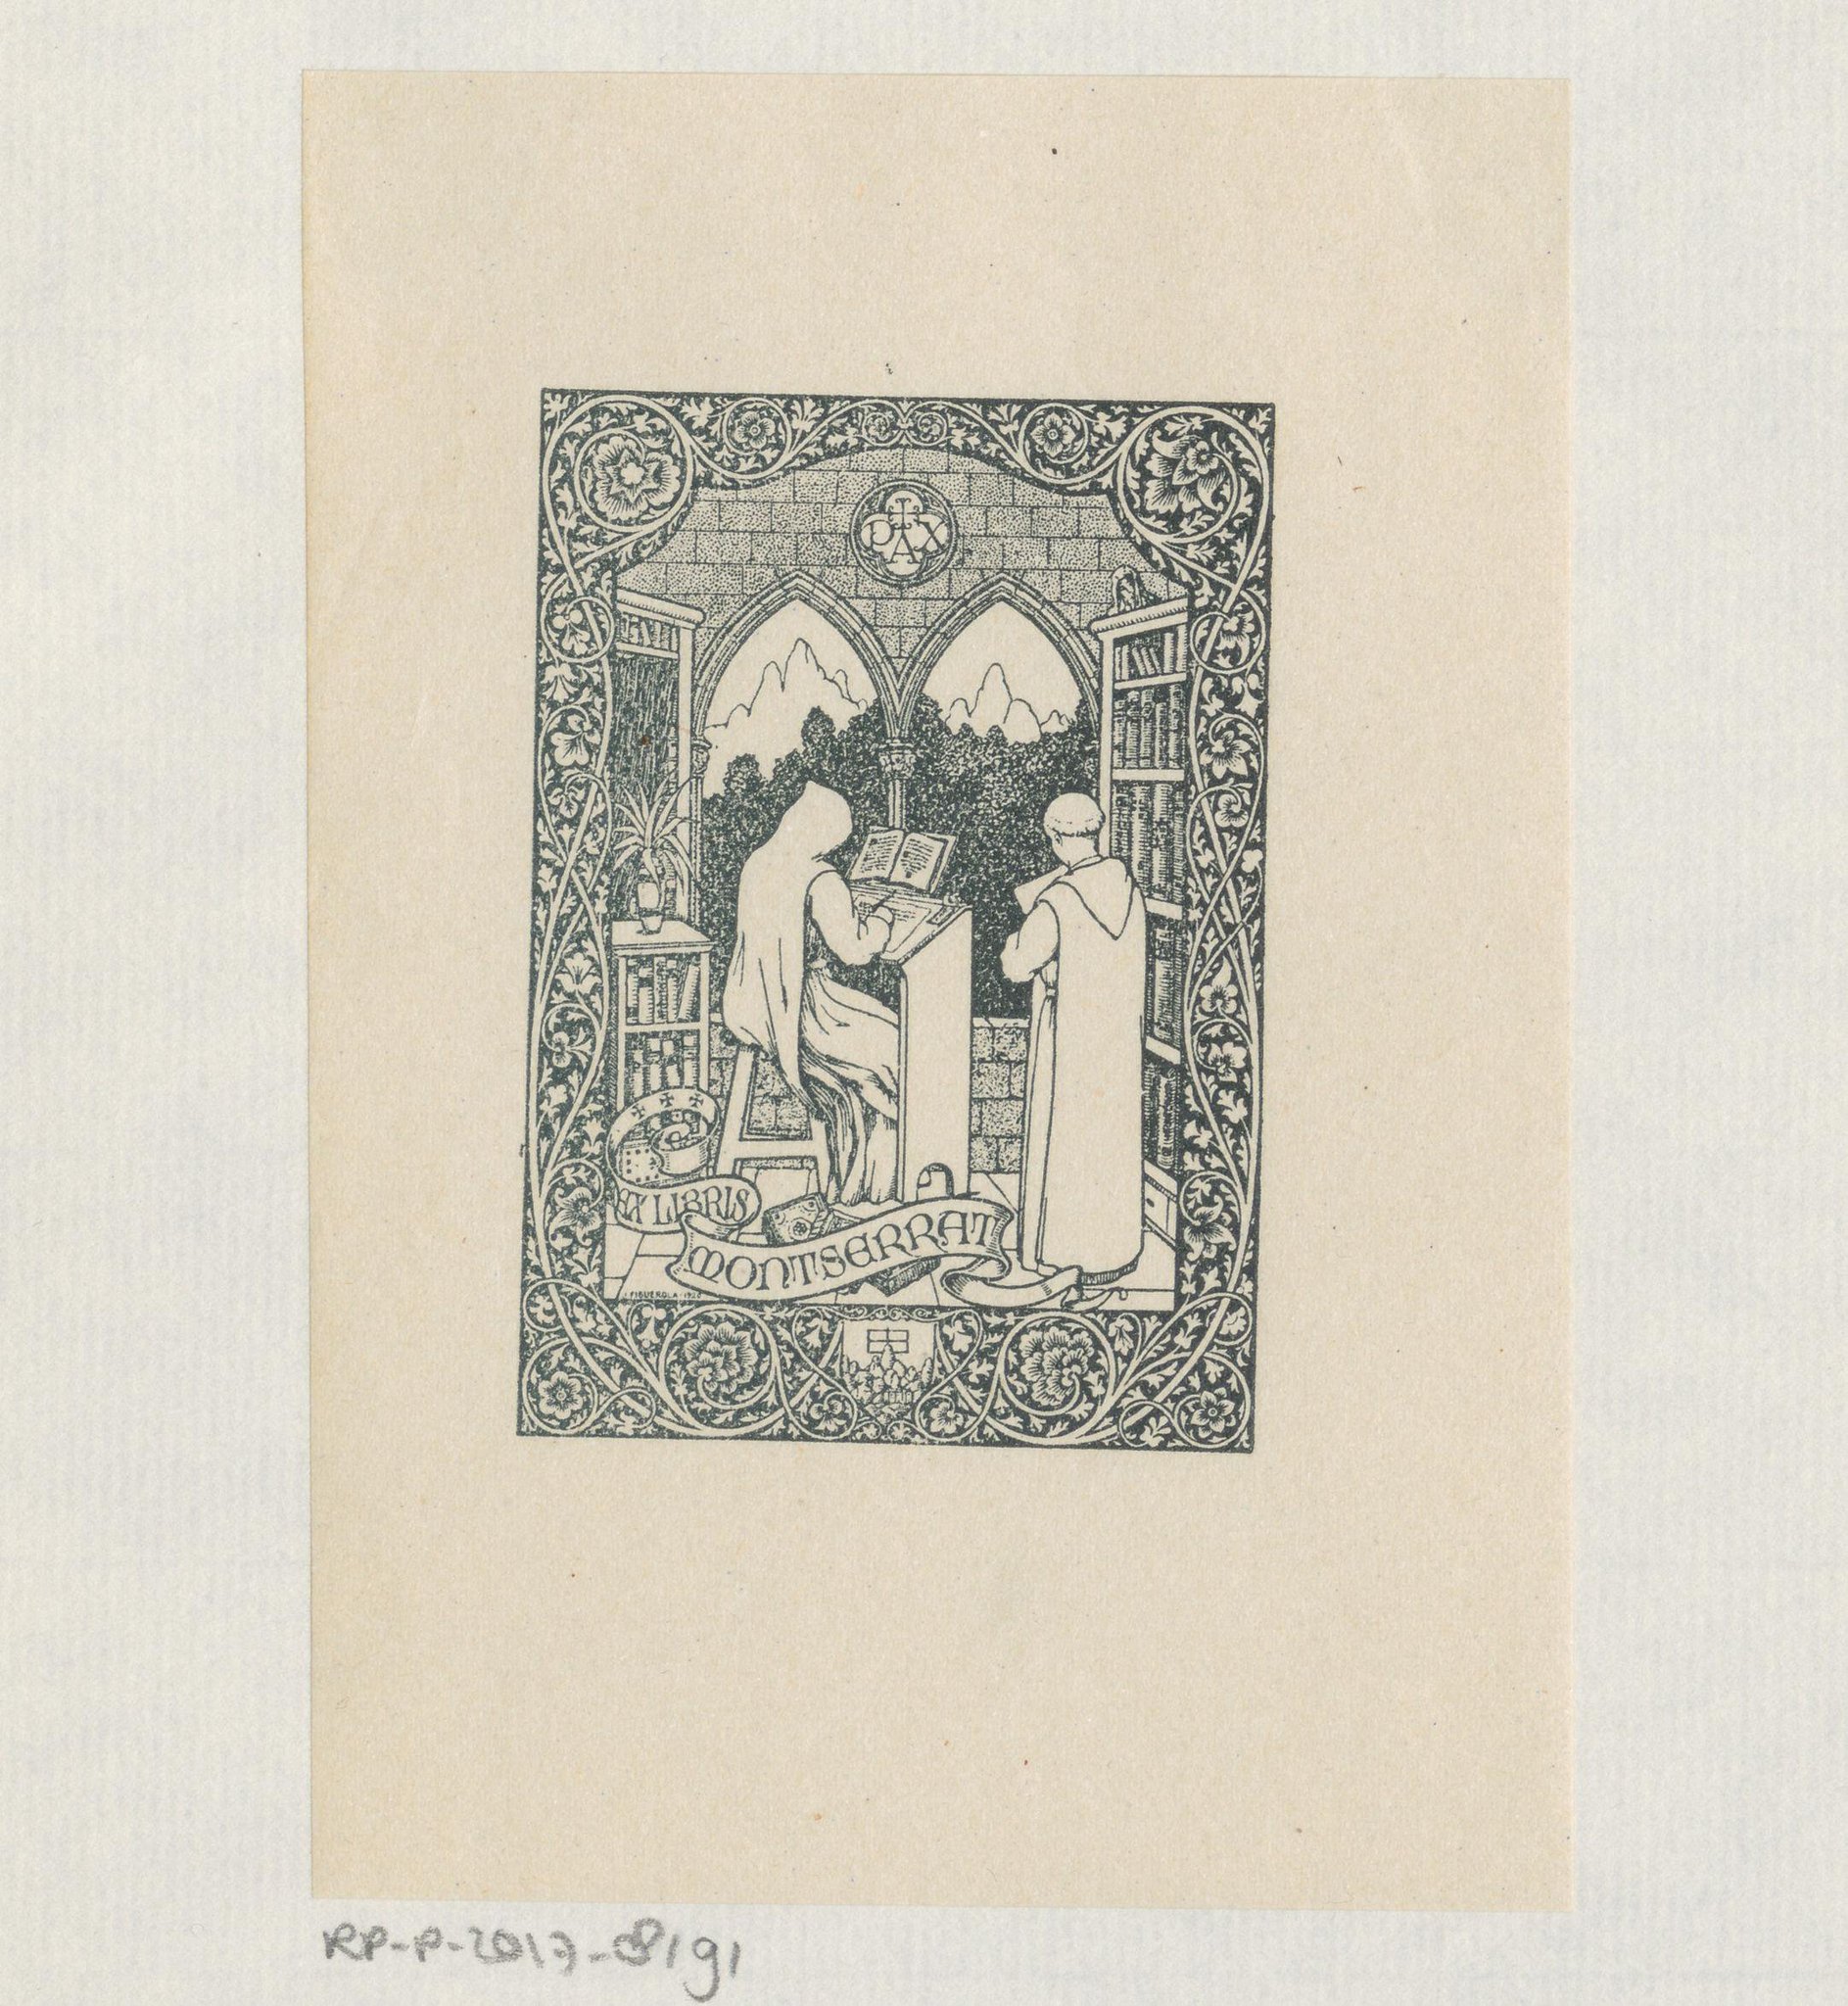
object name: bookplate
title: Ex libris Montserrat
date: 1920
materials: paper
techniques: printing block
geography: spain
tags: bookshelves, view through a window, monk(s), friar(s)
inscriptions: date